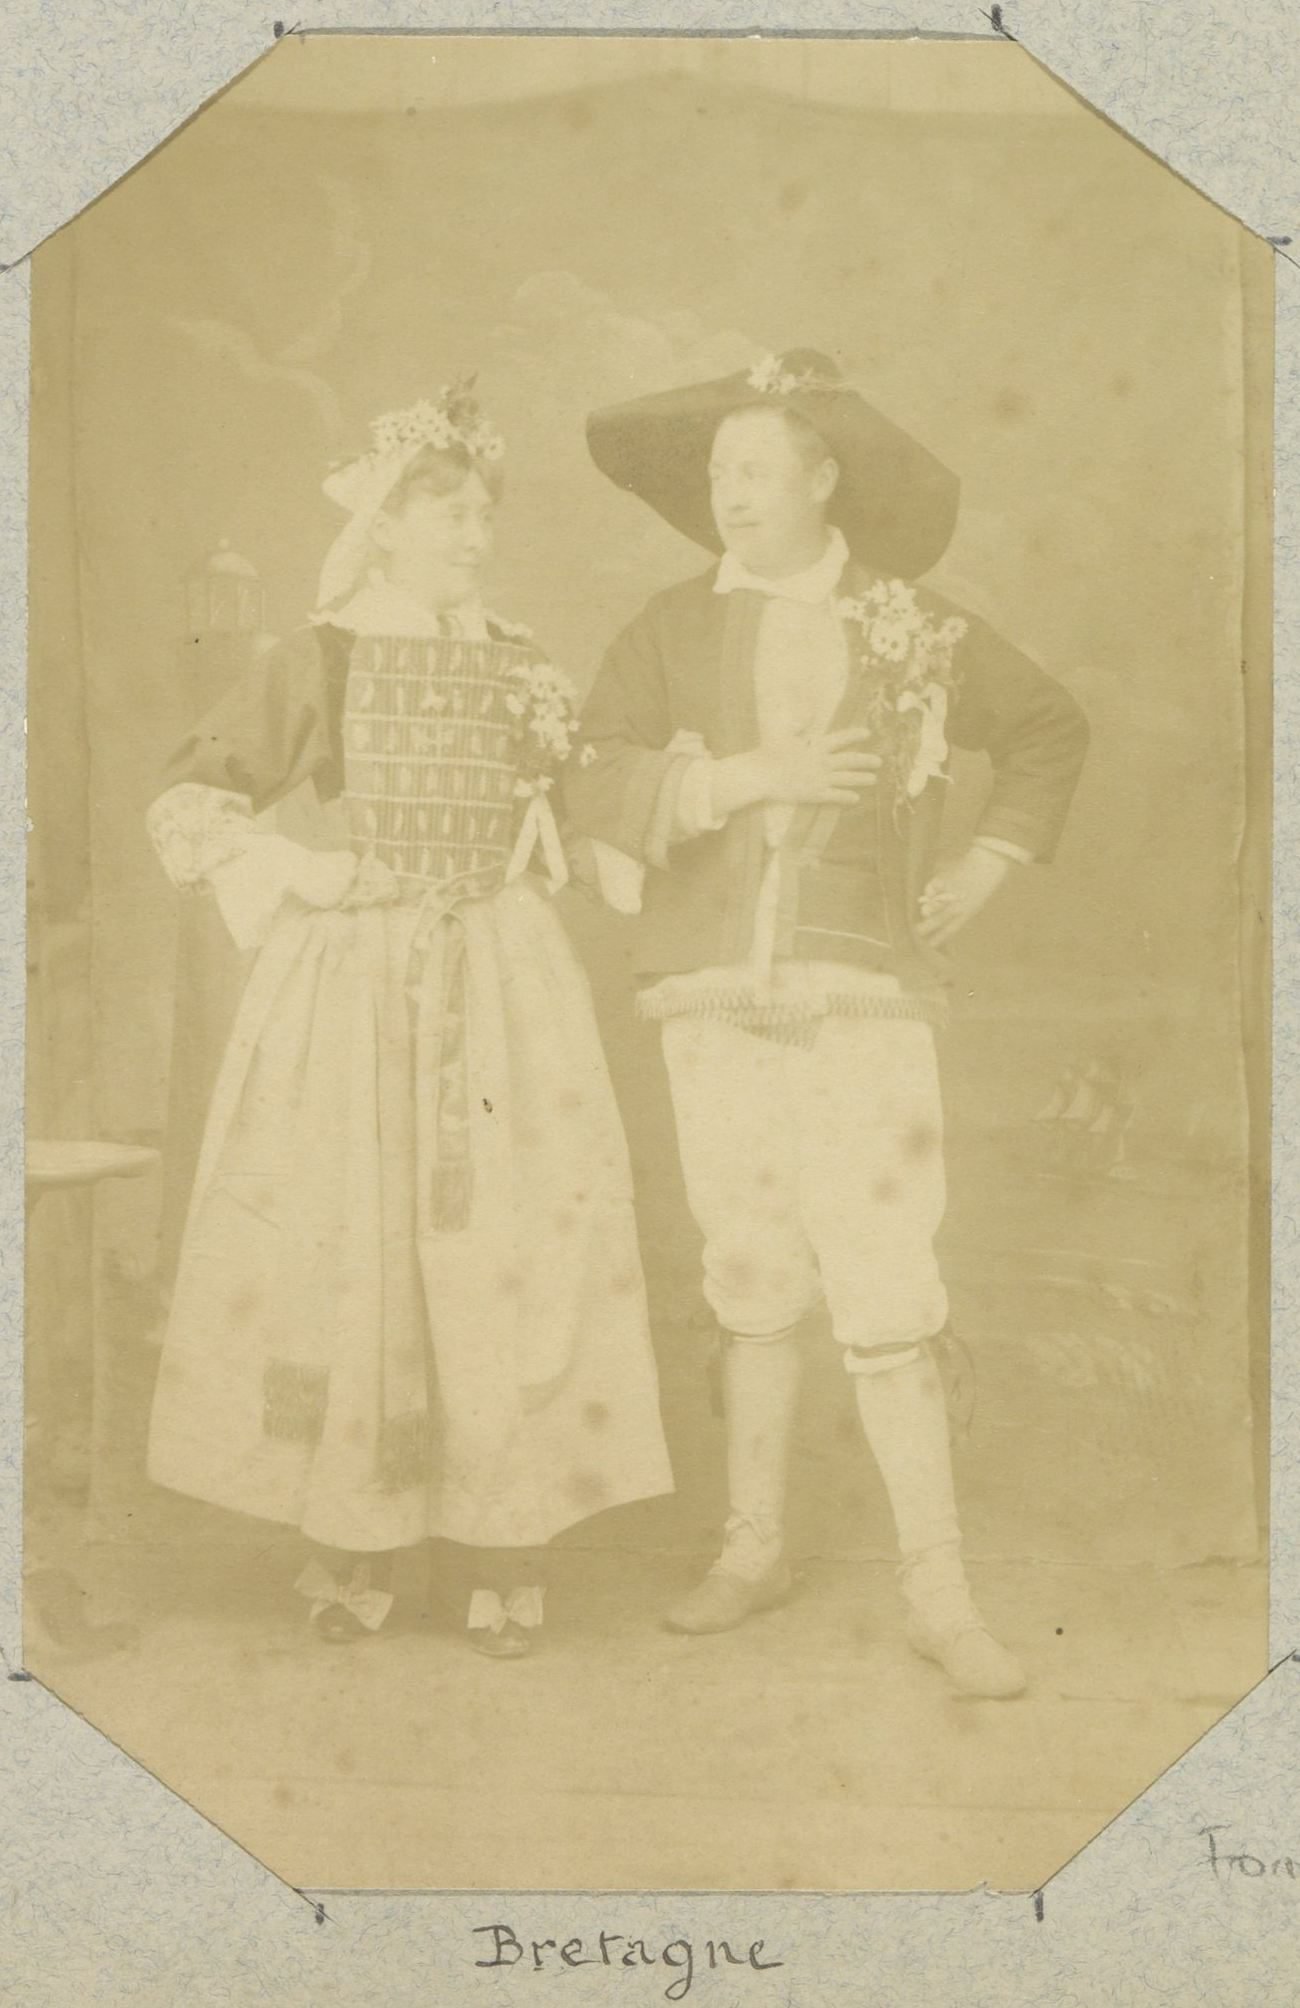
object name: album leaf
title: Portret van een Bretons paar in historisch kostuum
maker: Anonymous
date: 1890-1900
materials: paper, photographic support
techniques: albumen print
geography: brittany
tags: marriage, married couple, 'matrimonium', head-gear: hat, historical costume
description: Waarschijnlijk gaat het hier om kostuums geïnspireerd op daadwerkelijke klederdracht uit Bourg de Batz. Toeristen lieten zich aan het eind van de 19e eeuw in dergelijke kostuums fotograferen bij een bezoek aan de badplaats.